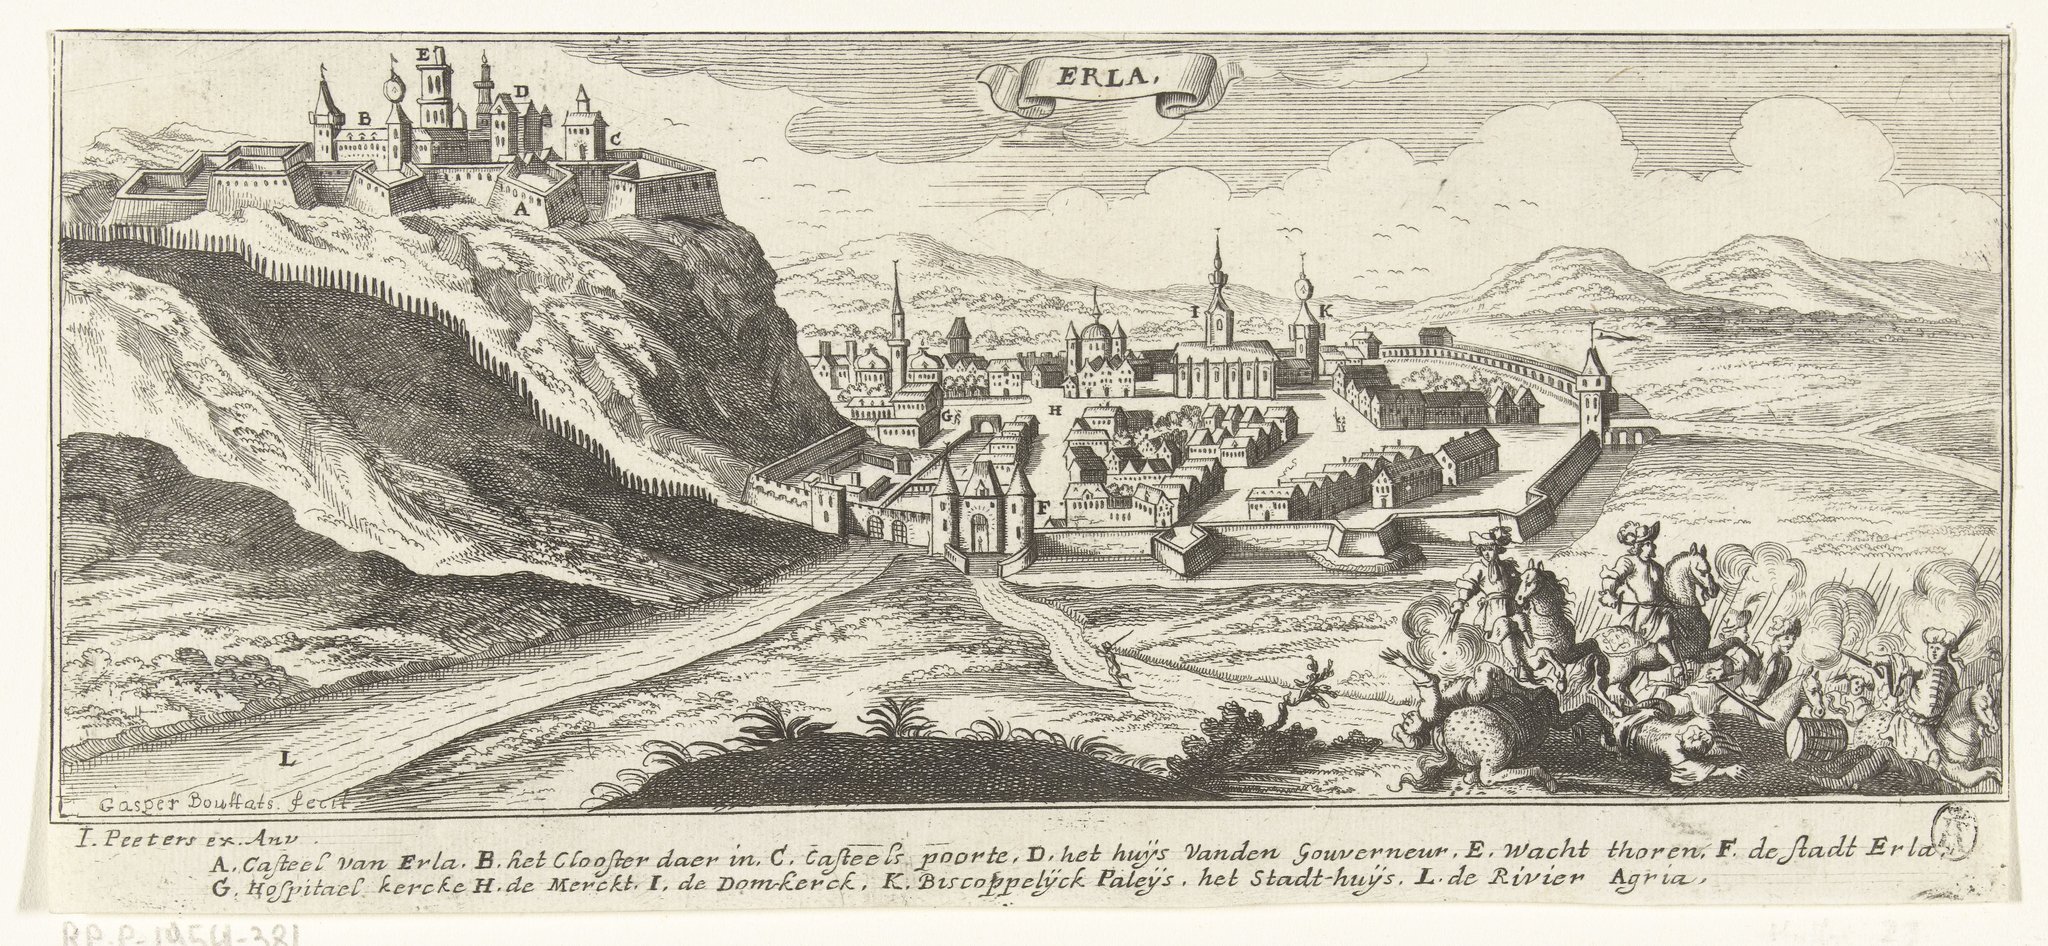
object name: print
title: Korte beschryvinghe, en de aen-wysinghe der plaetsen in desen boeck, met hunnen teghen woordighen standt, pertinentelijk uyt-ghebeldt, in Oostenryck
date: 1686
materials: paper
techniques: etching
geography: antwerp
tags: prospect of city, town panorama, silhouette of city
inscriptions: collector's mark: Lugt 2760, collector's mark: Lugt 2228, collector's mark: Lugt 971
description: Gezicht op de stad Eger. Op de voorgrond, buiten de stadsmuren, een gevecht tussen Hongaarse en Ottomaanse legereenheden. Boven het stadsgezicht een cartouche met de naam van de stad. De prent heeft een Nederlands onderschrift met verwijzingen naar gebouwen op de prent.